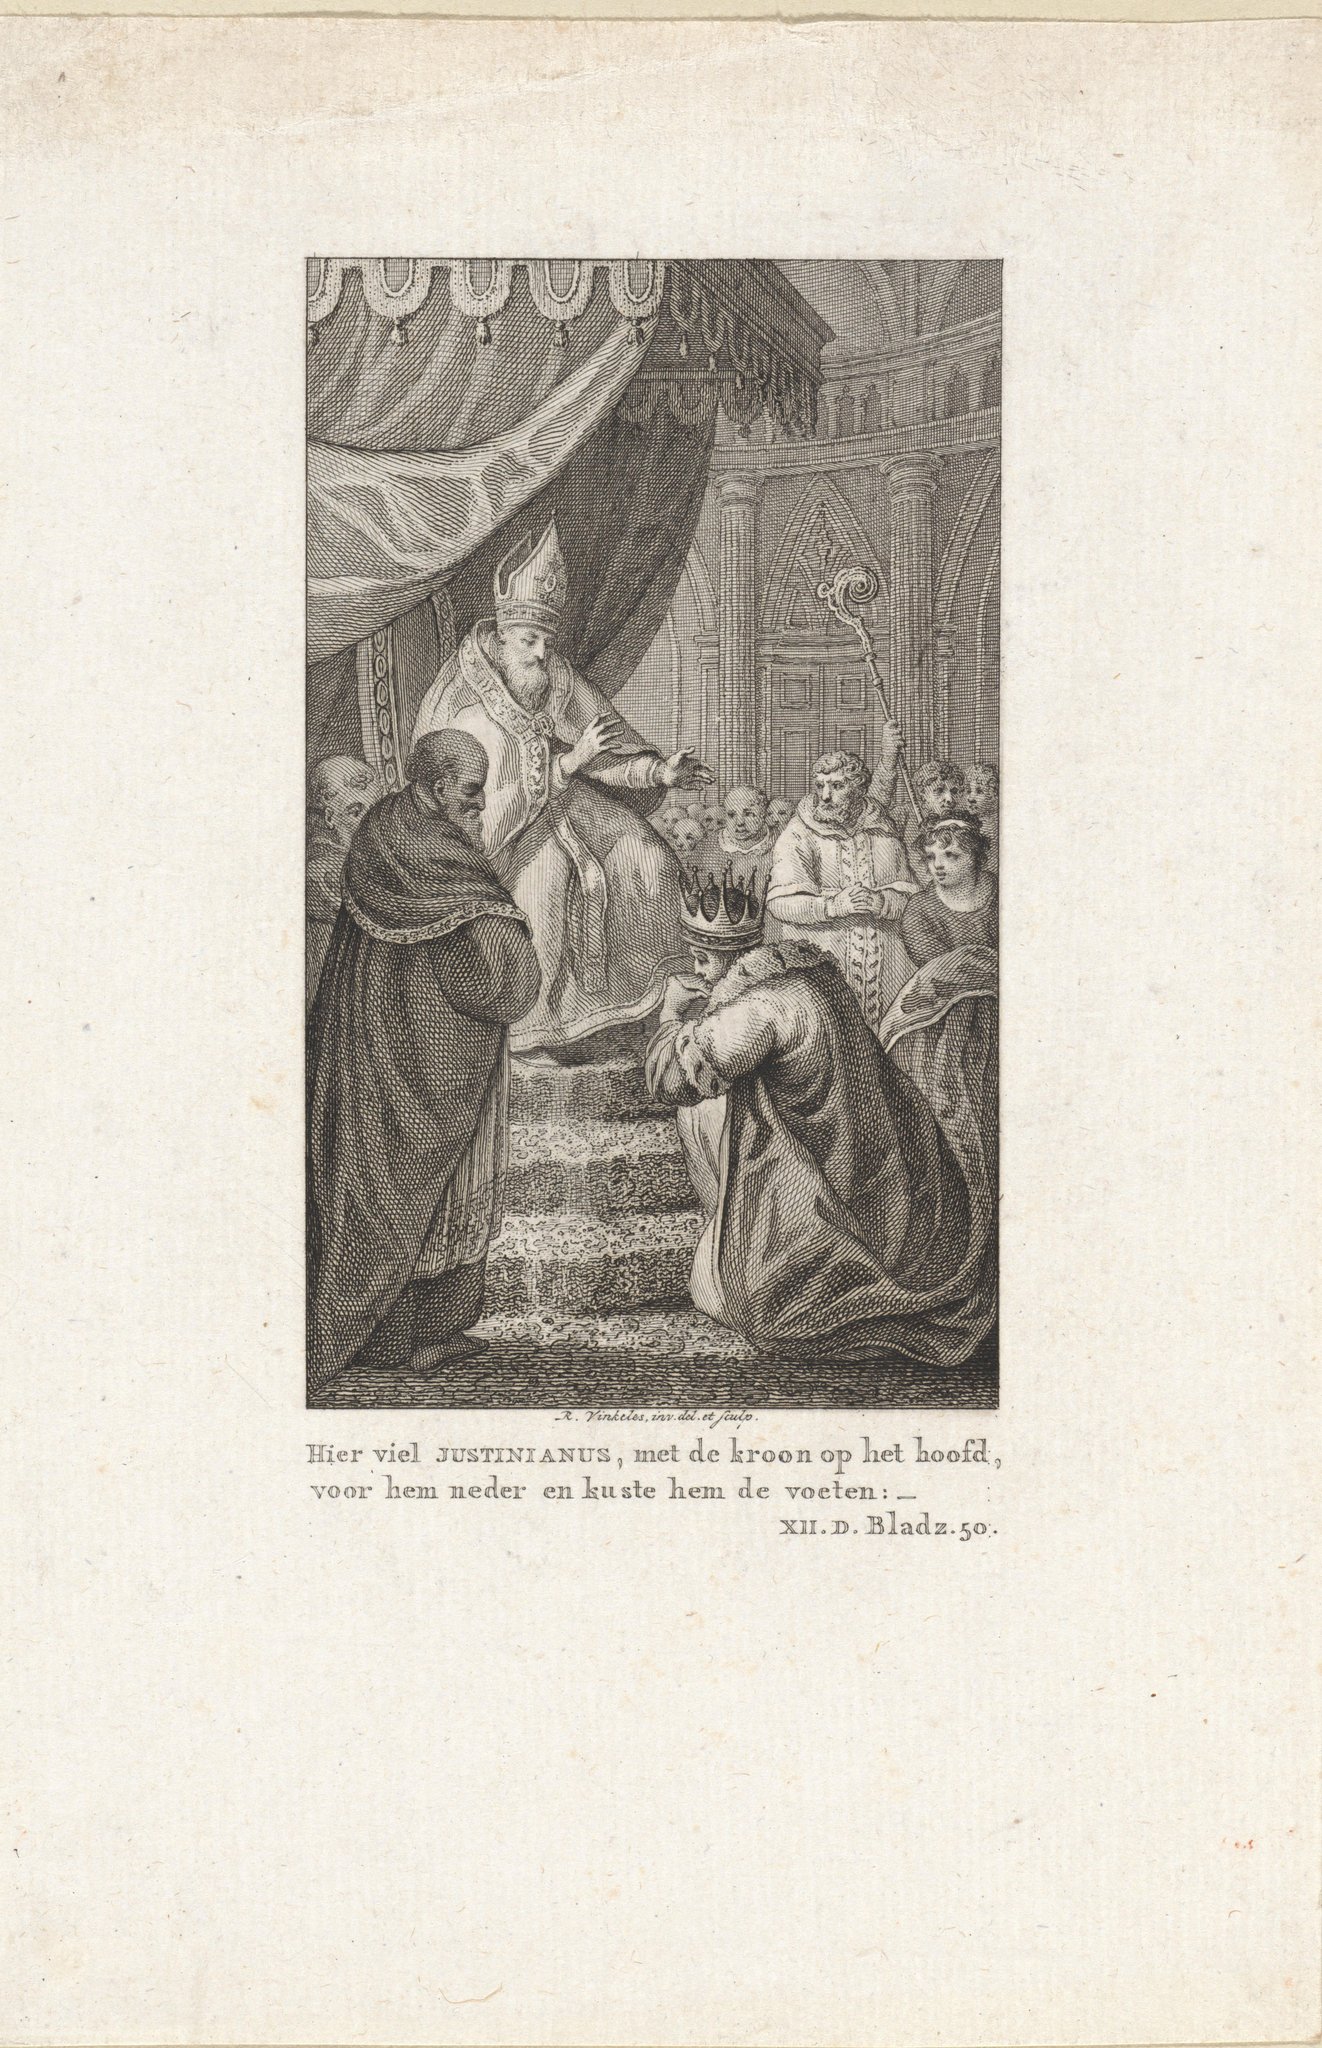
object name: print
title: Hier viel Justinianus (...)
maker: reinier vinkeles (i)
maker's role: draughtsman, print maker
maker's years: 1741-1816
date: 1806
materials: paper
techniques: engraving, etching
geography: amsterdam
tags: kissing the pope's feet, ruler, sovereign, insignia and symbols of sovereignty (crown, diadem, sceptre, orb, seal, standard, cloak, pectoral)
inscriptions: collector's mark: Lugt 240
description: Illustratie in: Hamelsveld, Ysbrand van. Algemeene kerkelijke geschiedenis, der Christenen, deel 12. Haarlem: François Bohn, 1806, p. 50.